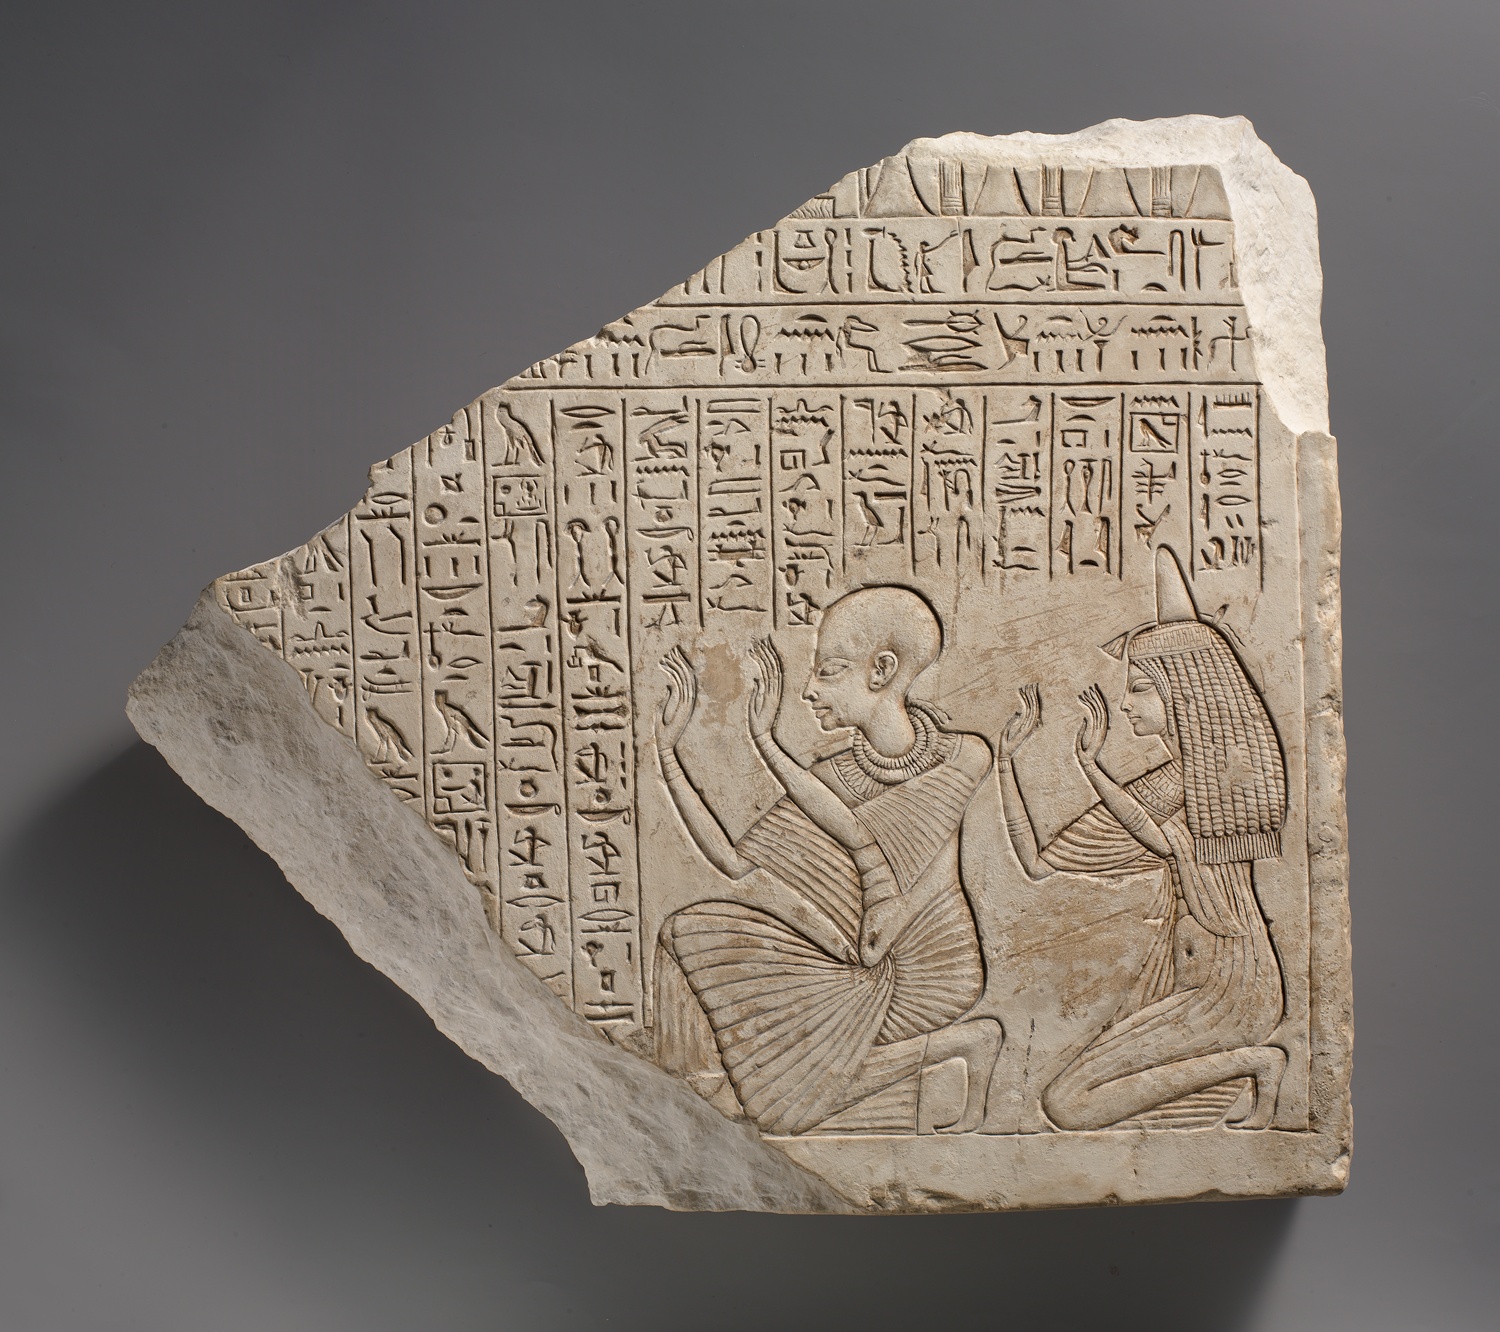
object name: stela, userhat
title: Votive stela of Userhat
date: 1327-1295 BCE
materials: limestone, paint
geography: egypt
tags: men,women,hieroglyphs